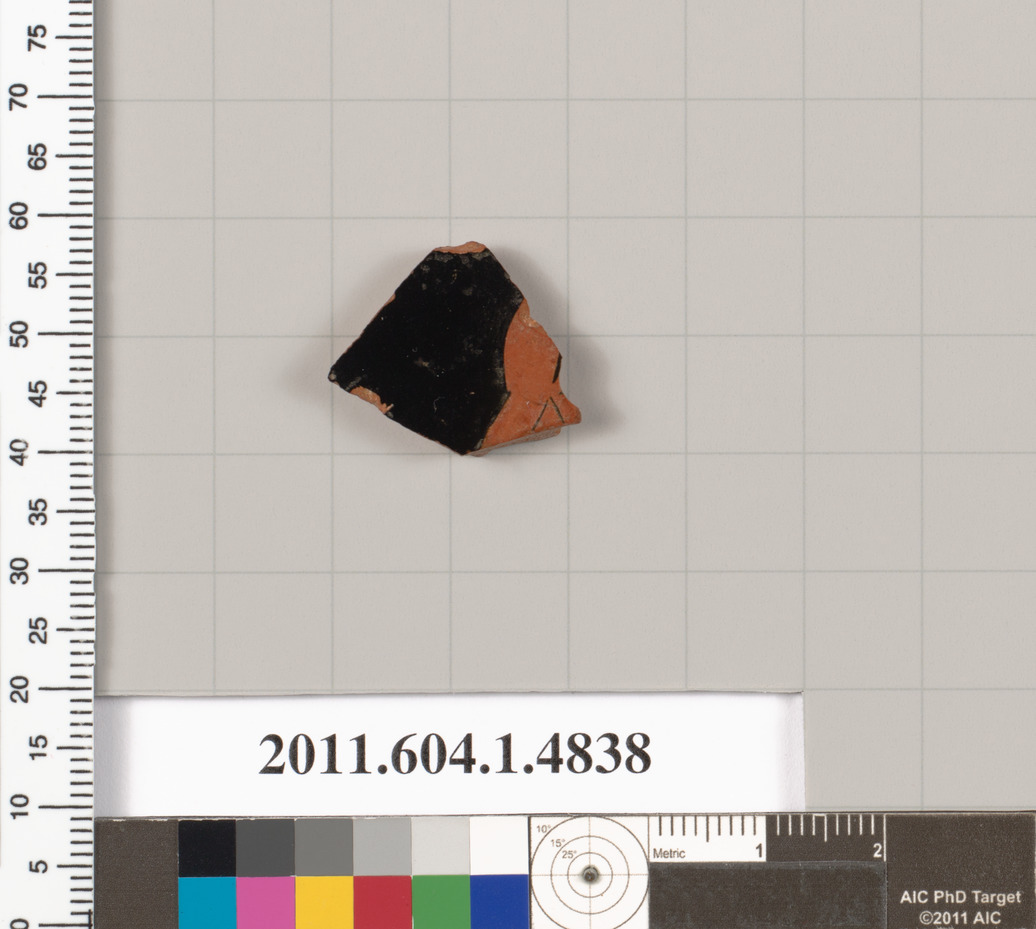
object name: kylix fragment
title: Terracotta fragment of a kylix (drinking cup)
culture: greek, attic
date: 500-480 BCE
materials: terracotta